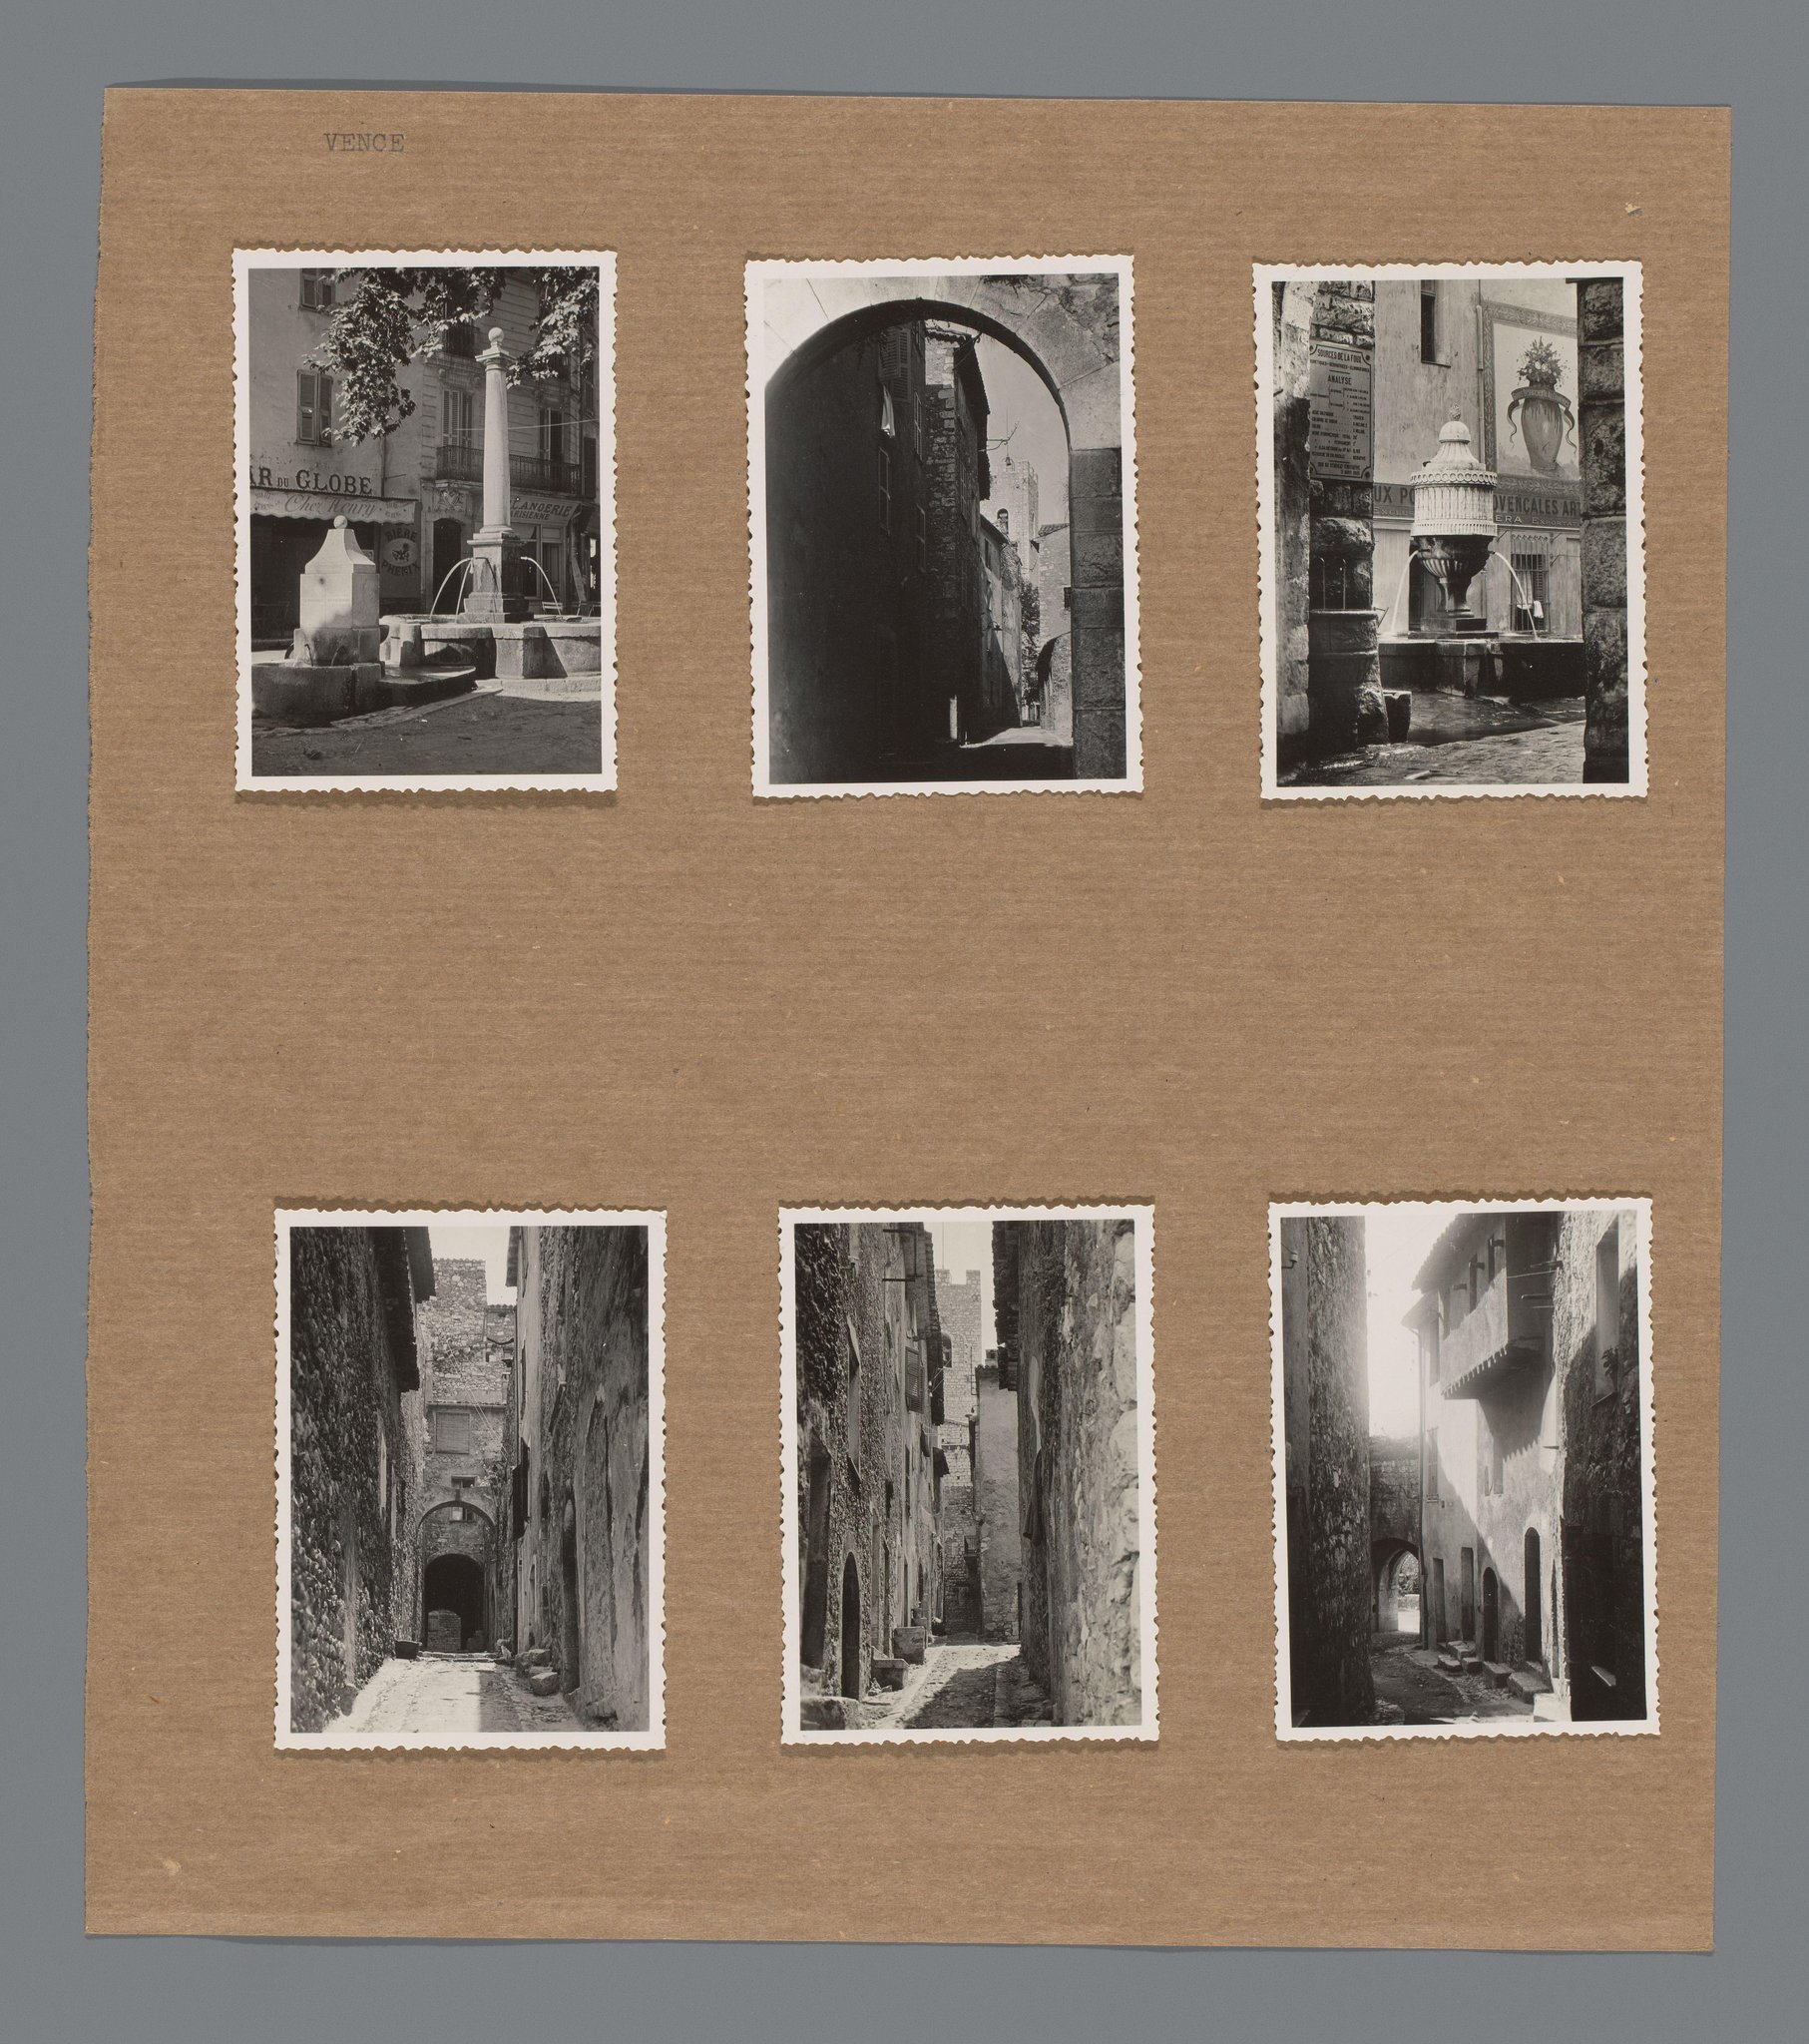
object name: photograph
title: Vence. France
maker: Anonymous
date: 1880-1920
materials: photographic support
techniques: gelatin silver print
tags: vence